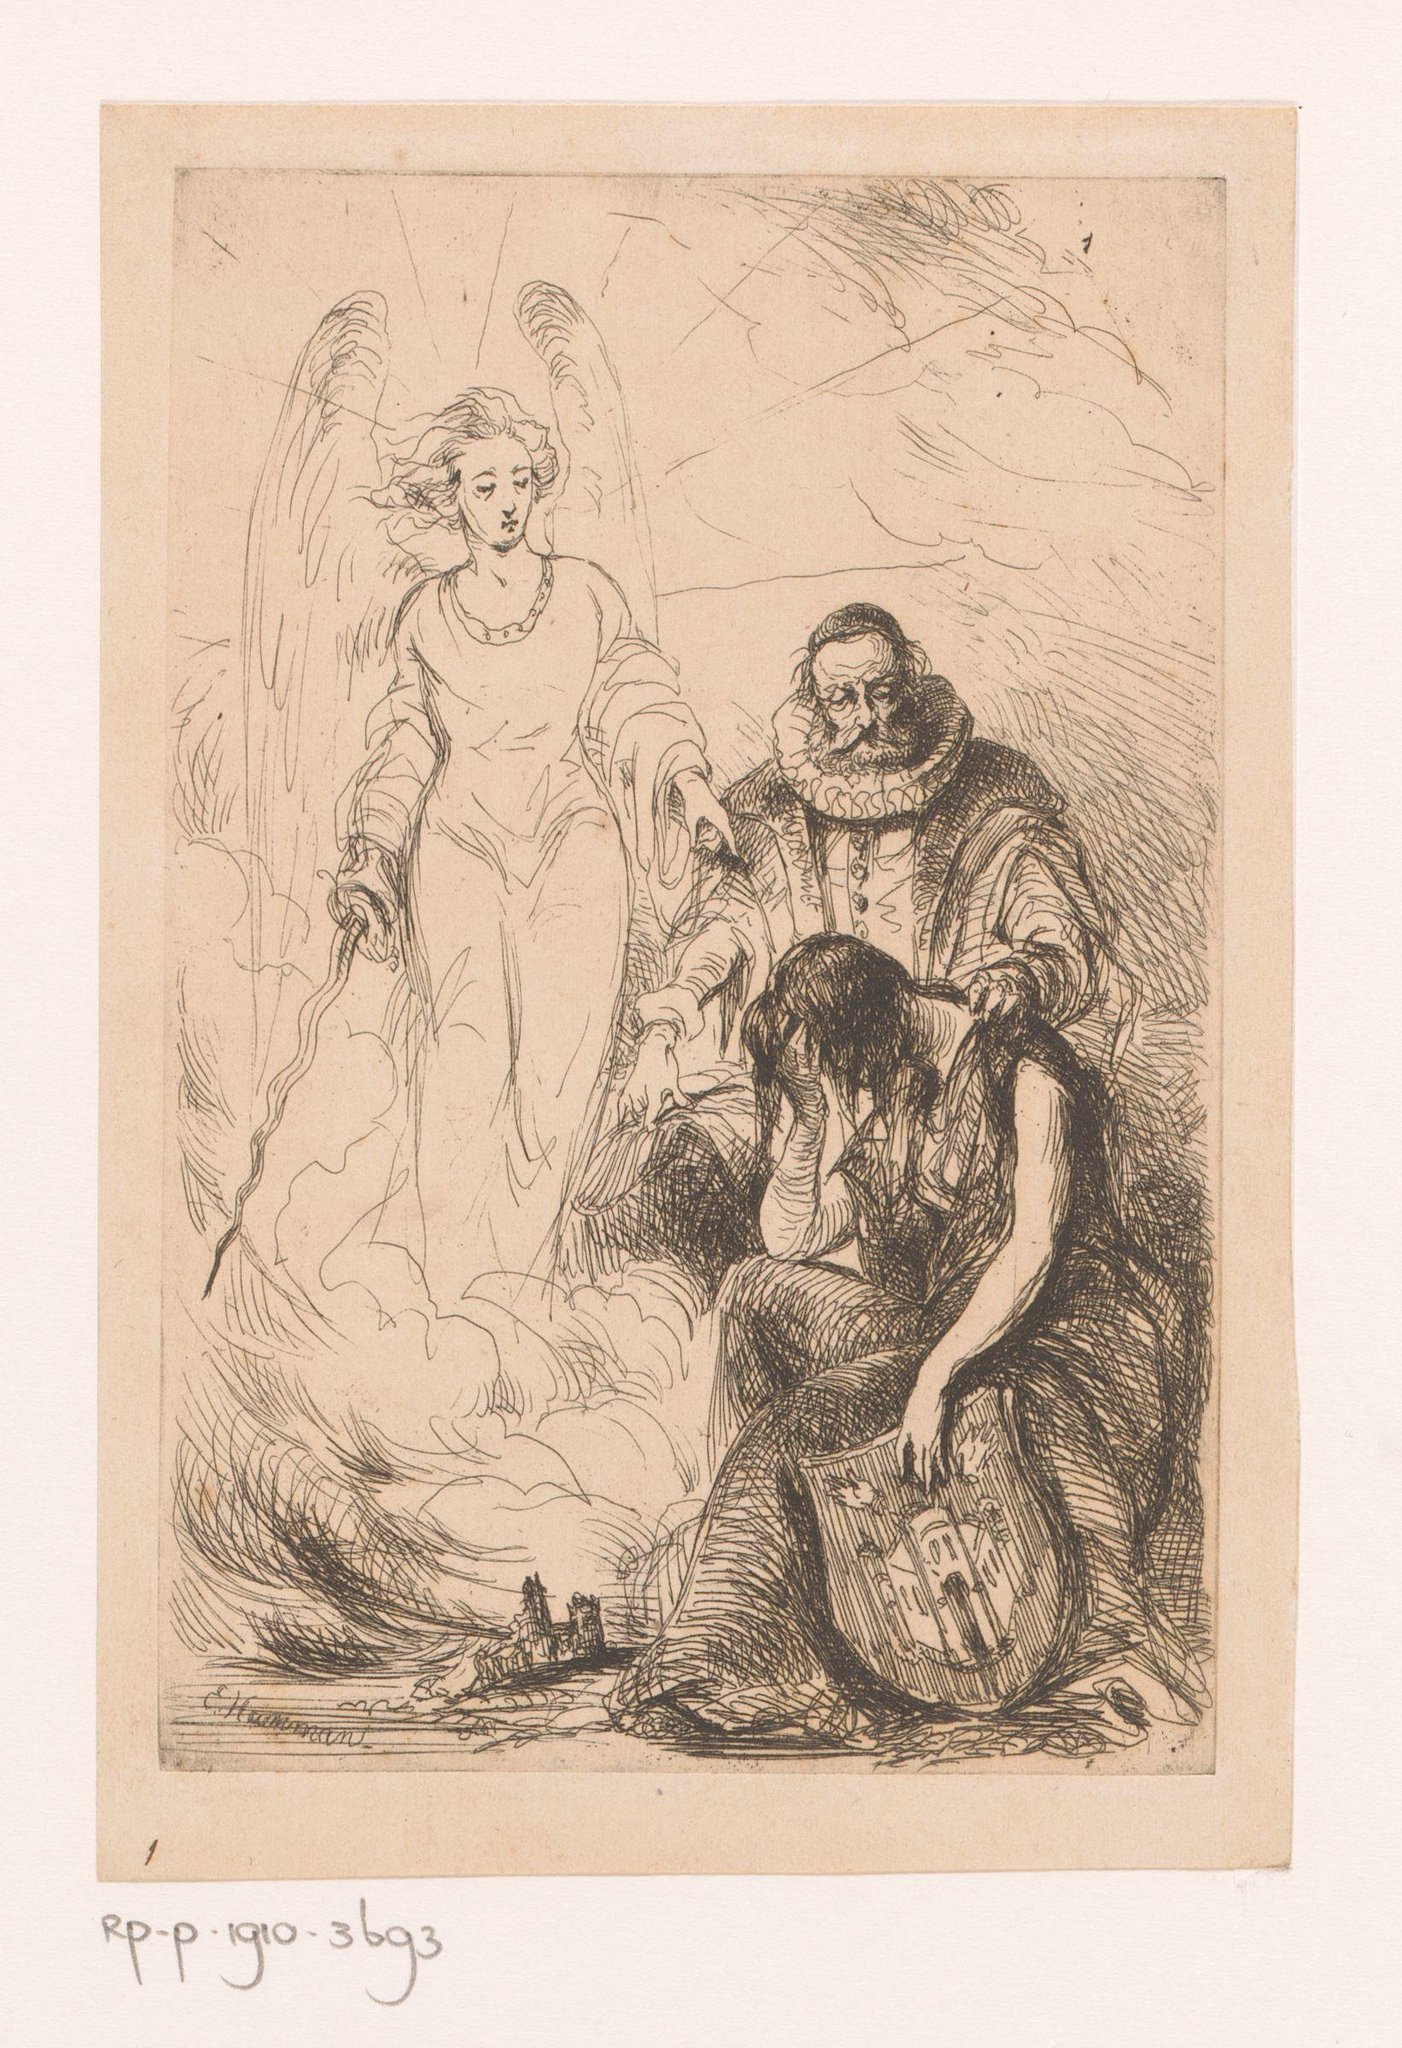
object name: print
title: Personificatie van Antwerpen met gebogen hoofd, daarachter een man met een hand op haar schouder en een engel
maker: edouard hamman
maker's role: draughtsman, print maker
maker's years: 1819-1888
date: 1842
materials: paper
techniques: etching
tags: personification of a city, town-patron(ess), angels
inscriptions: collector's mark: Lugt 2228, collector's mark: Lugt 1485